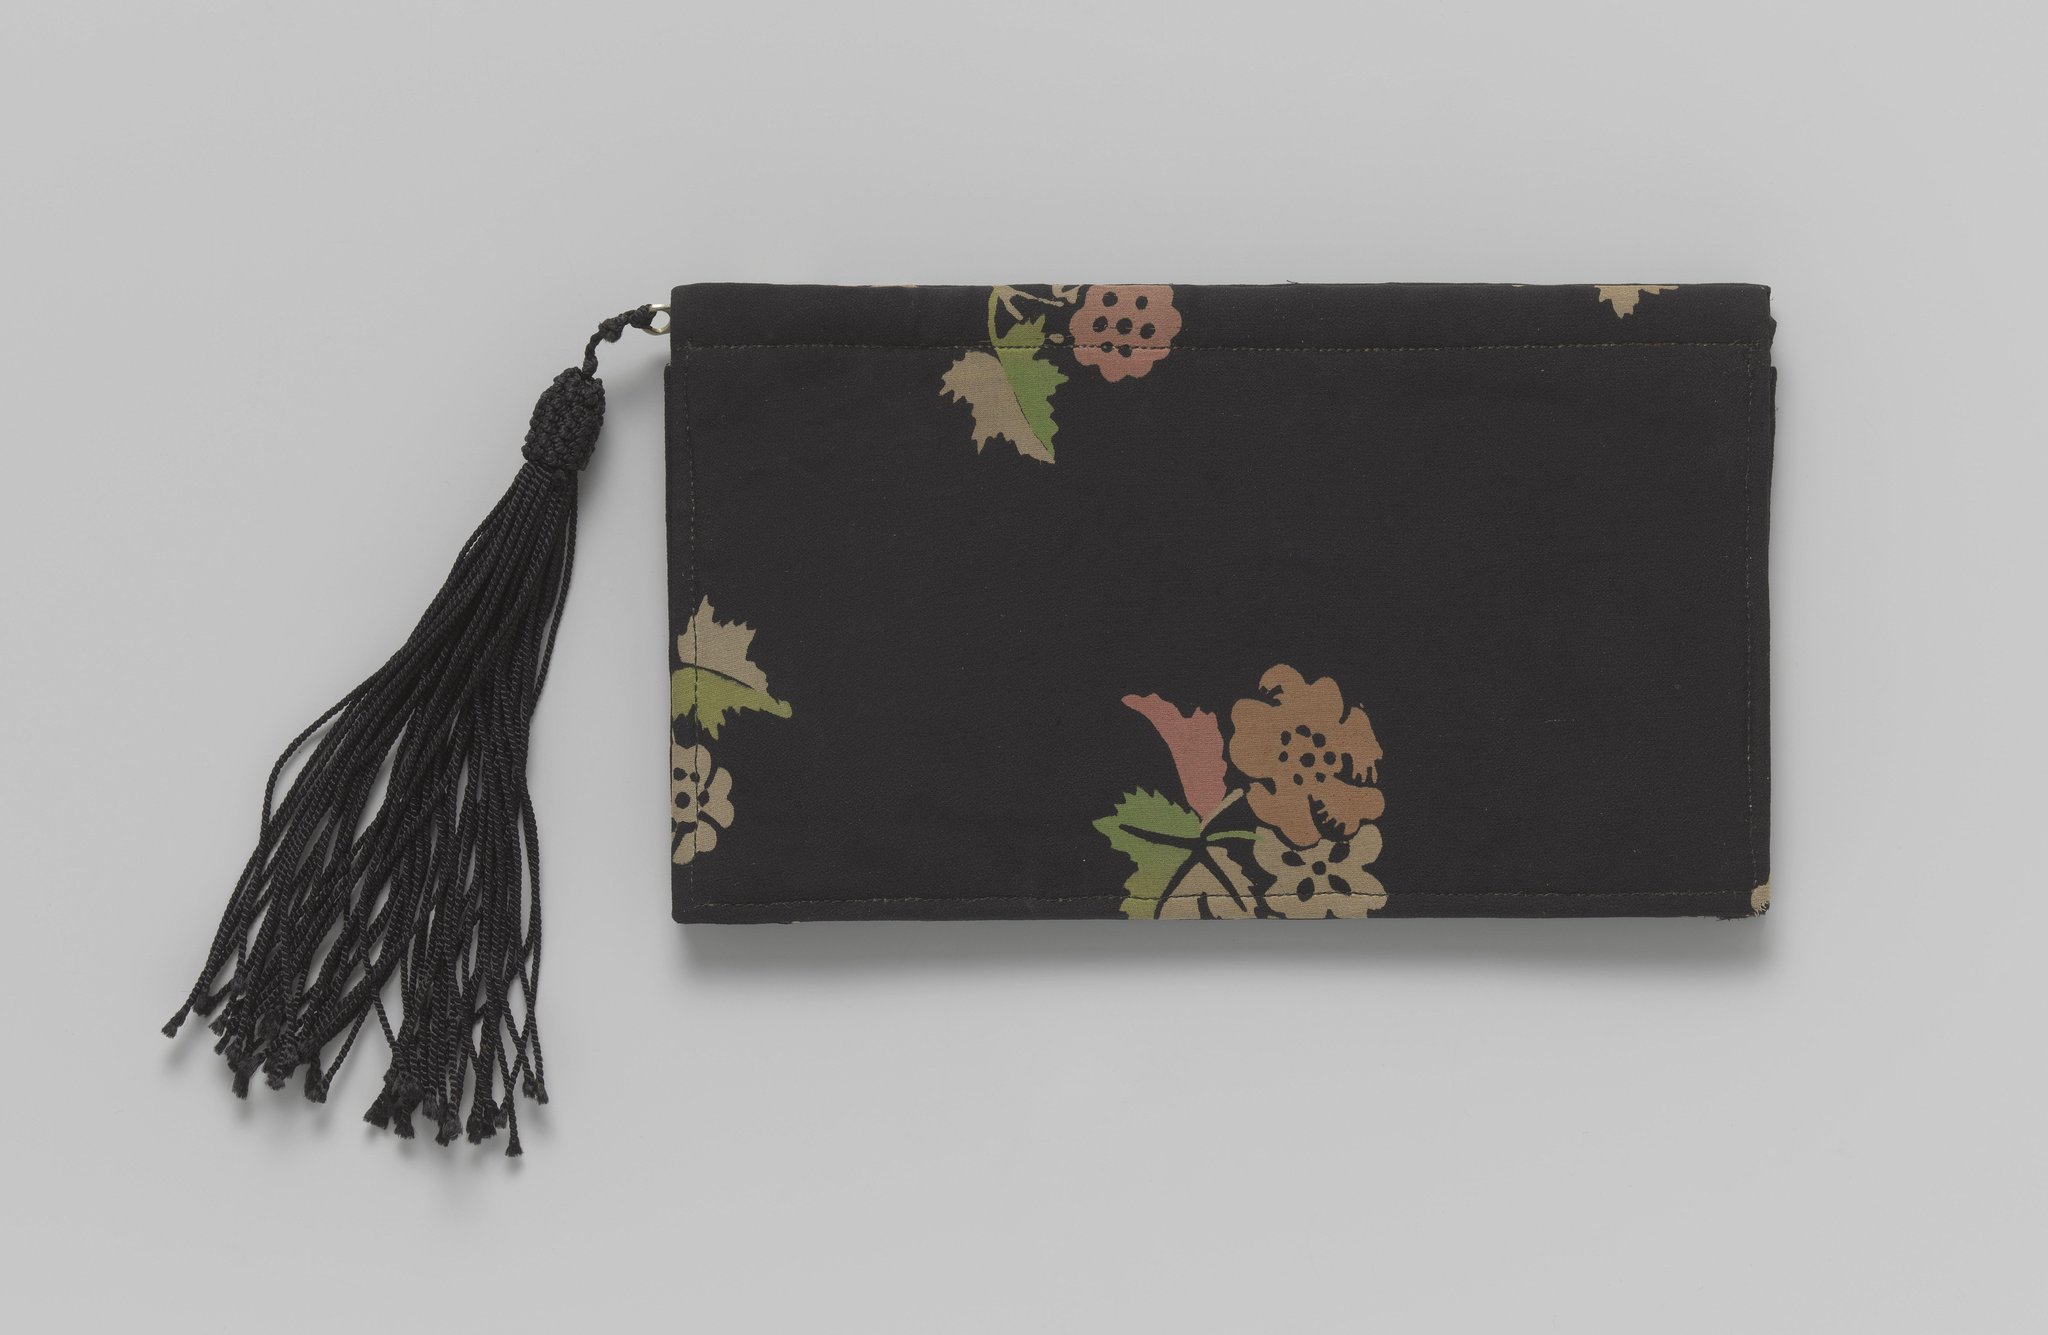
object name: evening bag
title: Avondtas van zwart bedrukt textiel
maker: Anonymous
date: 1910-1940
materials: textile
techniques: printing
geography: europe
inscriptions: mark: ‘Well’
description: Rechthoekige zwarte tas met florale bedrukking. De tas sluit met een zilverkleurige rits en is van binnen wit gevoerd. Aan de rits zit een zwarte kwast.